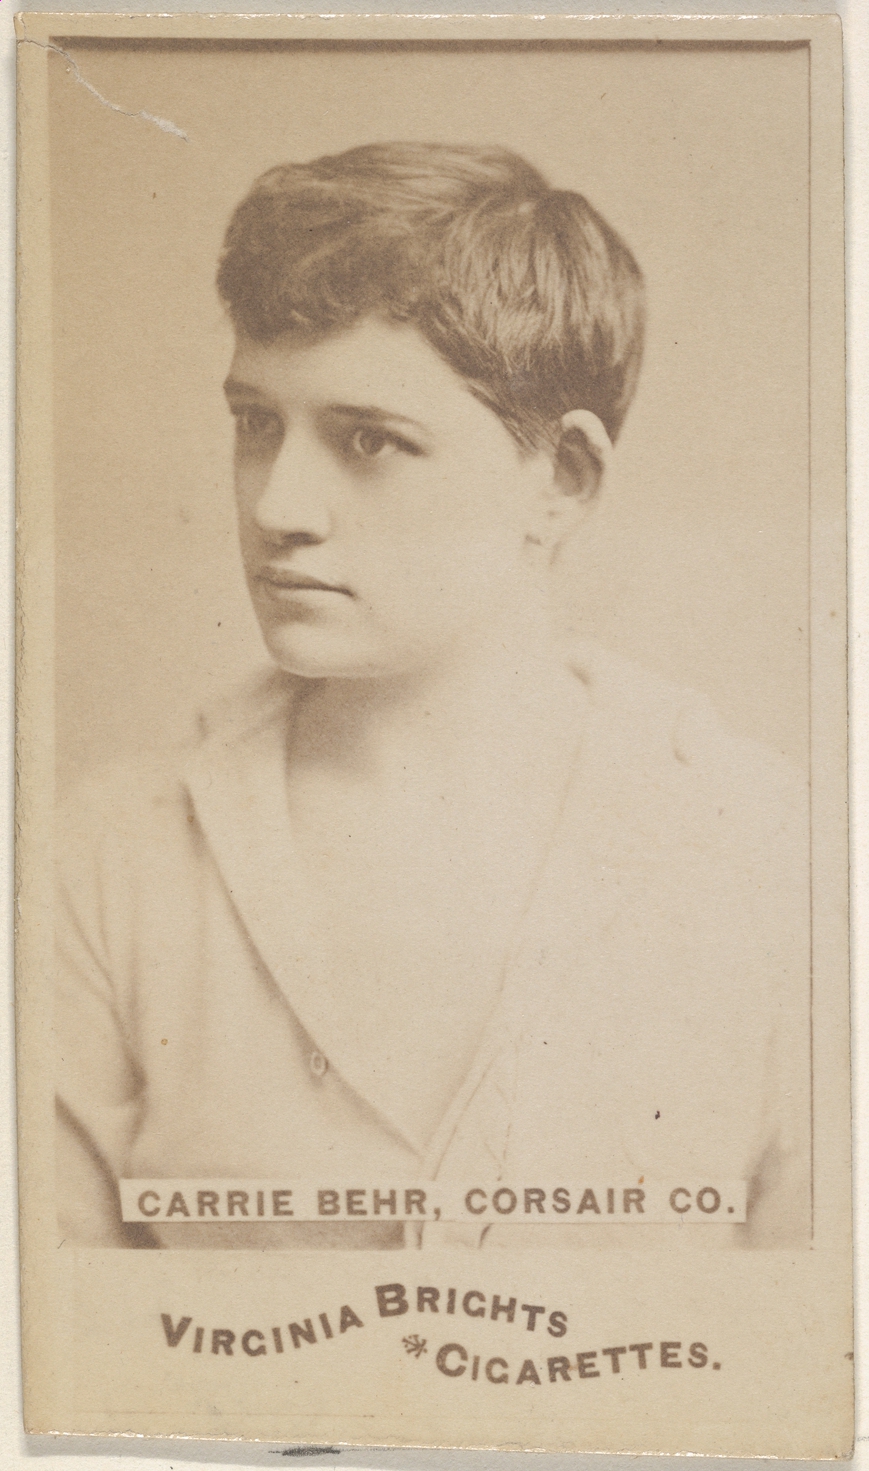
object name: photograph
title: Carrie Behr, Corsair Co., from the Actors and Actresses series (N45, Type 6) for Virginia Brights Cigarettes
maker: allen & ginter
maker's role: publisher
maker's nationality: american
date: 1888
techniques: albumen silver print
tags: portraits,women,actresses